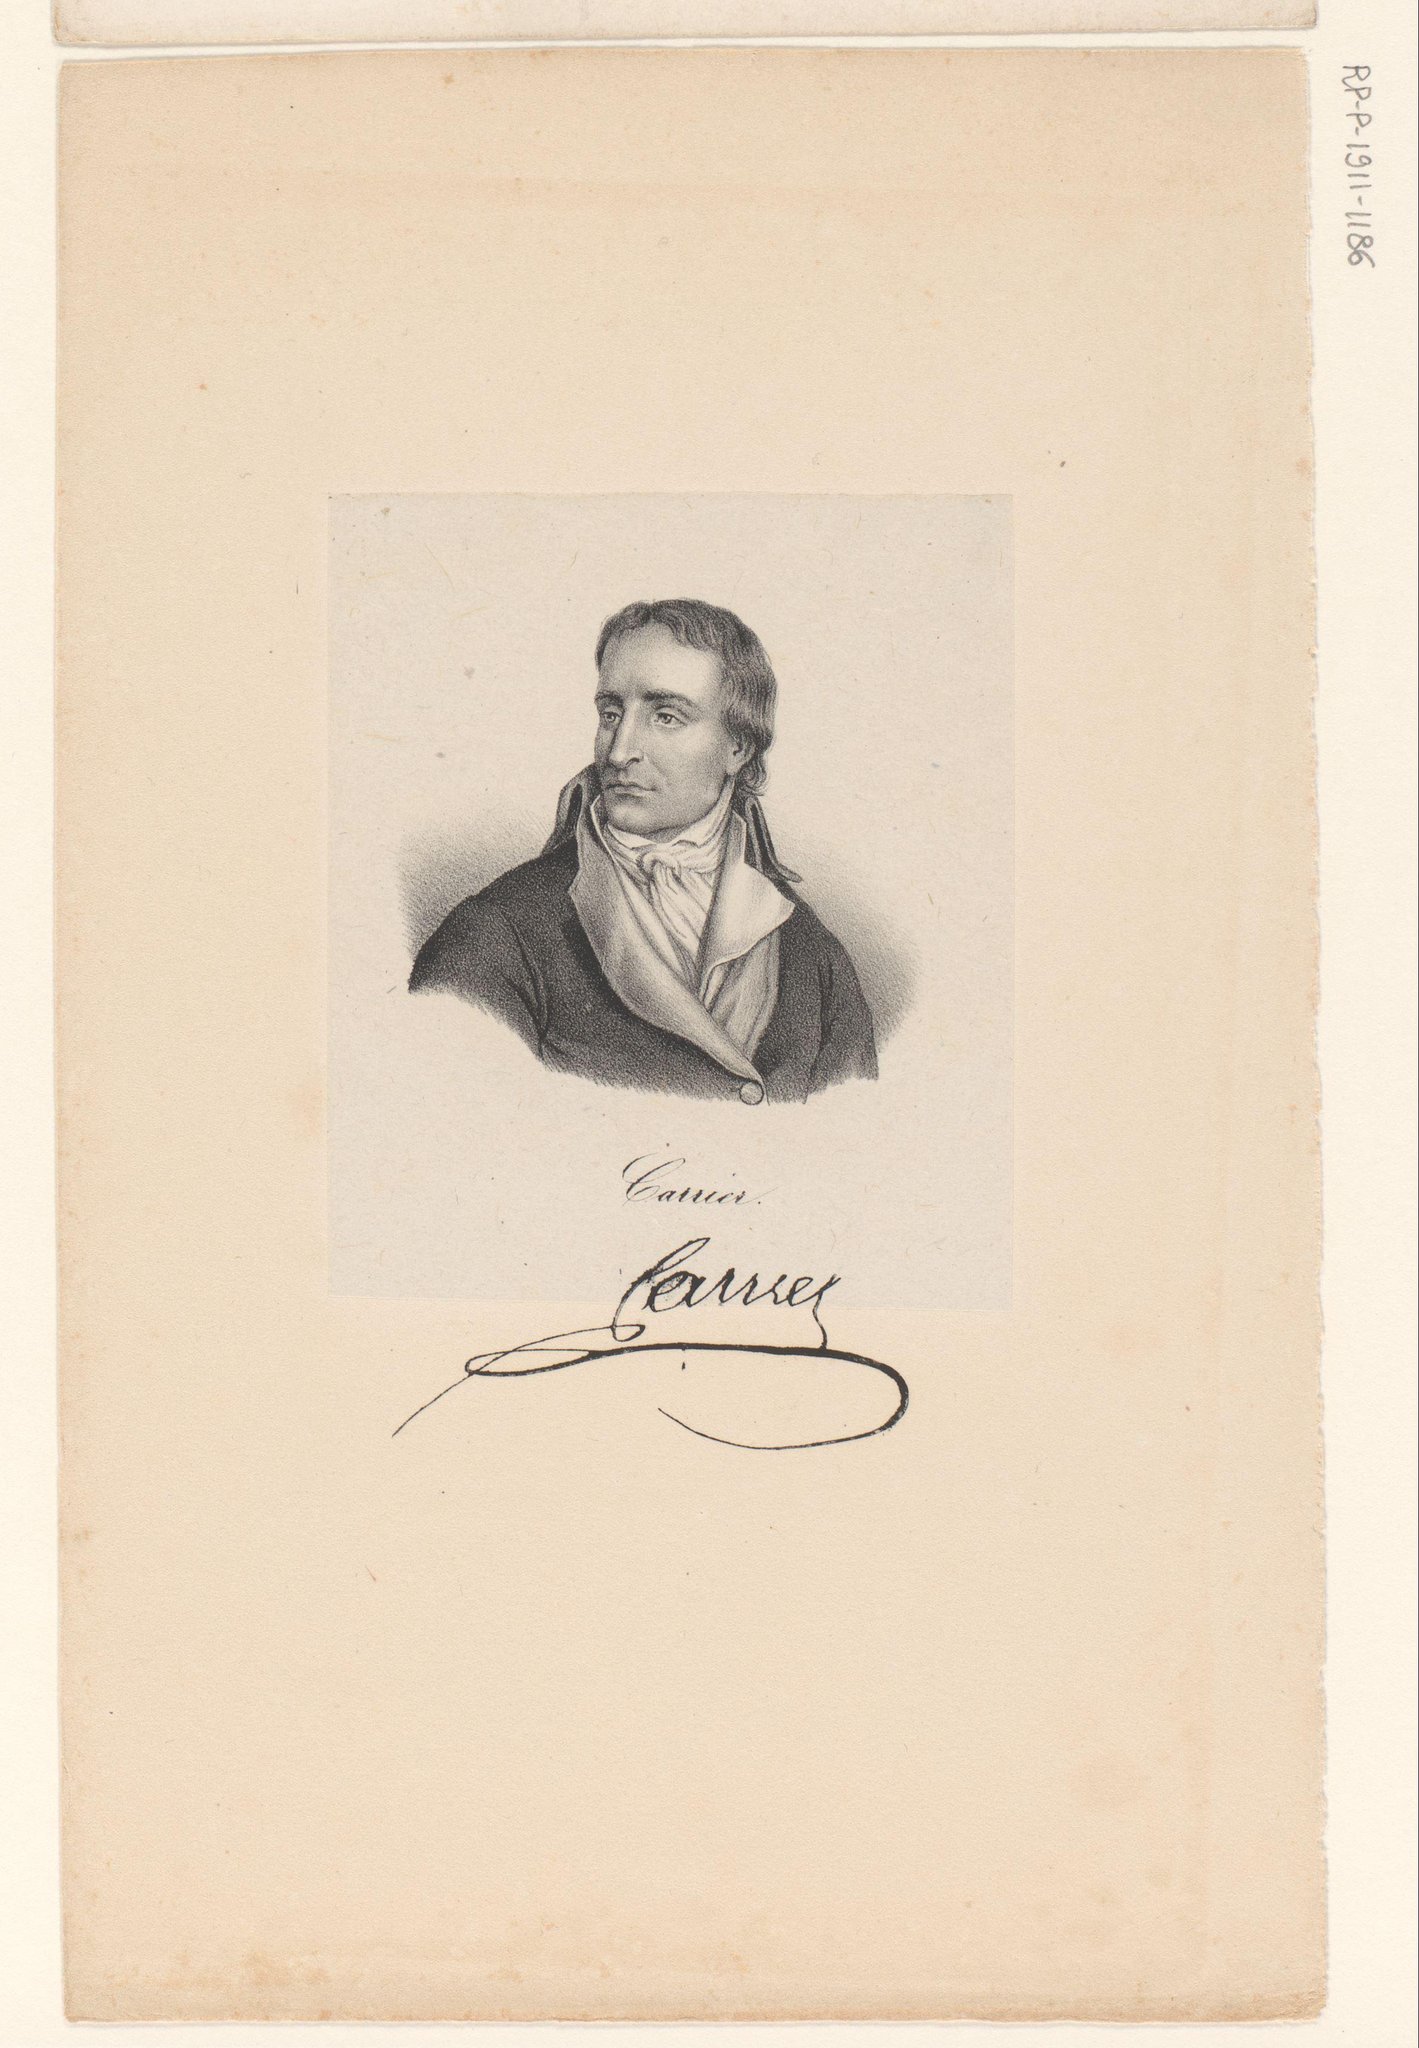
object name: print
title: Carrier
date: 1818-1842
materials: paper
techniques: lithograph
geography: paris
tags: paris, politician, historical persons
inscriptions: collector's mark: Lugt 2228a